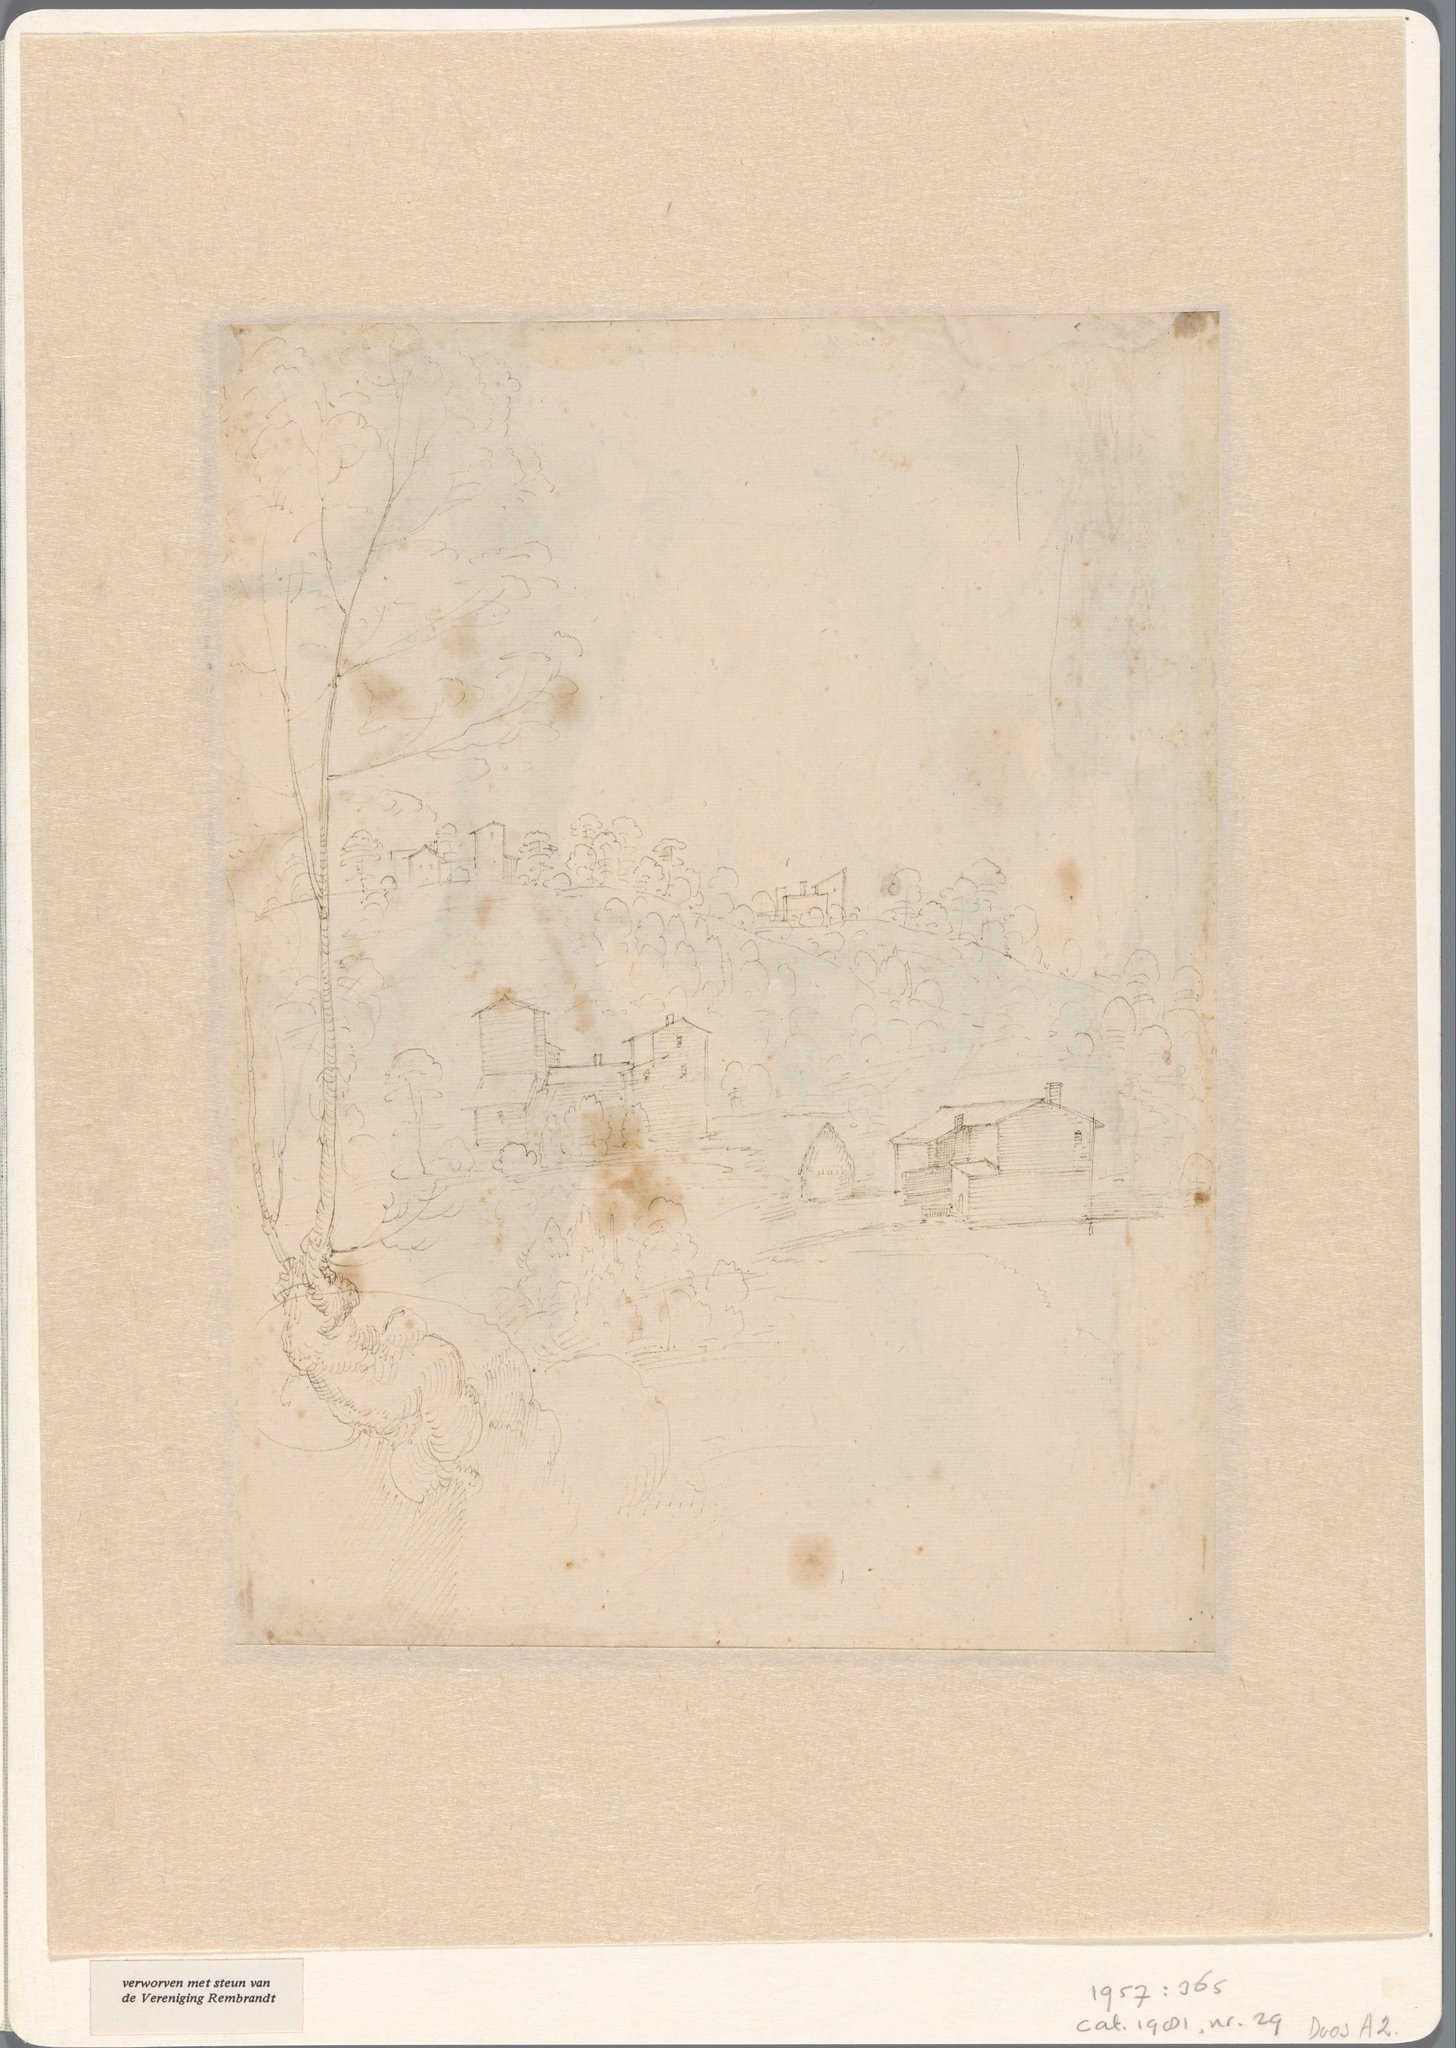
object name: drawing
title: Toscaans landschap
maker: bartolommeo (fra)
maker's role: draughtsman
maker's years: 1472-1517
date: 1485-1517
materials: ink, paper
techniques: pen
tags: toscane